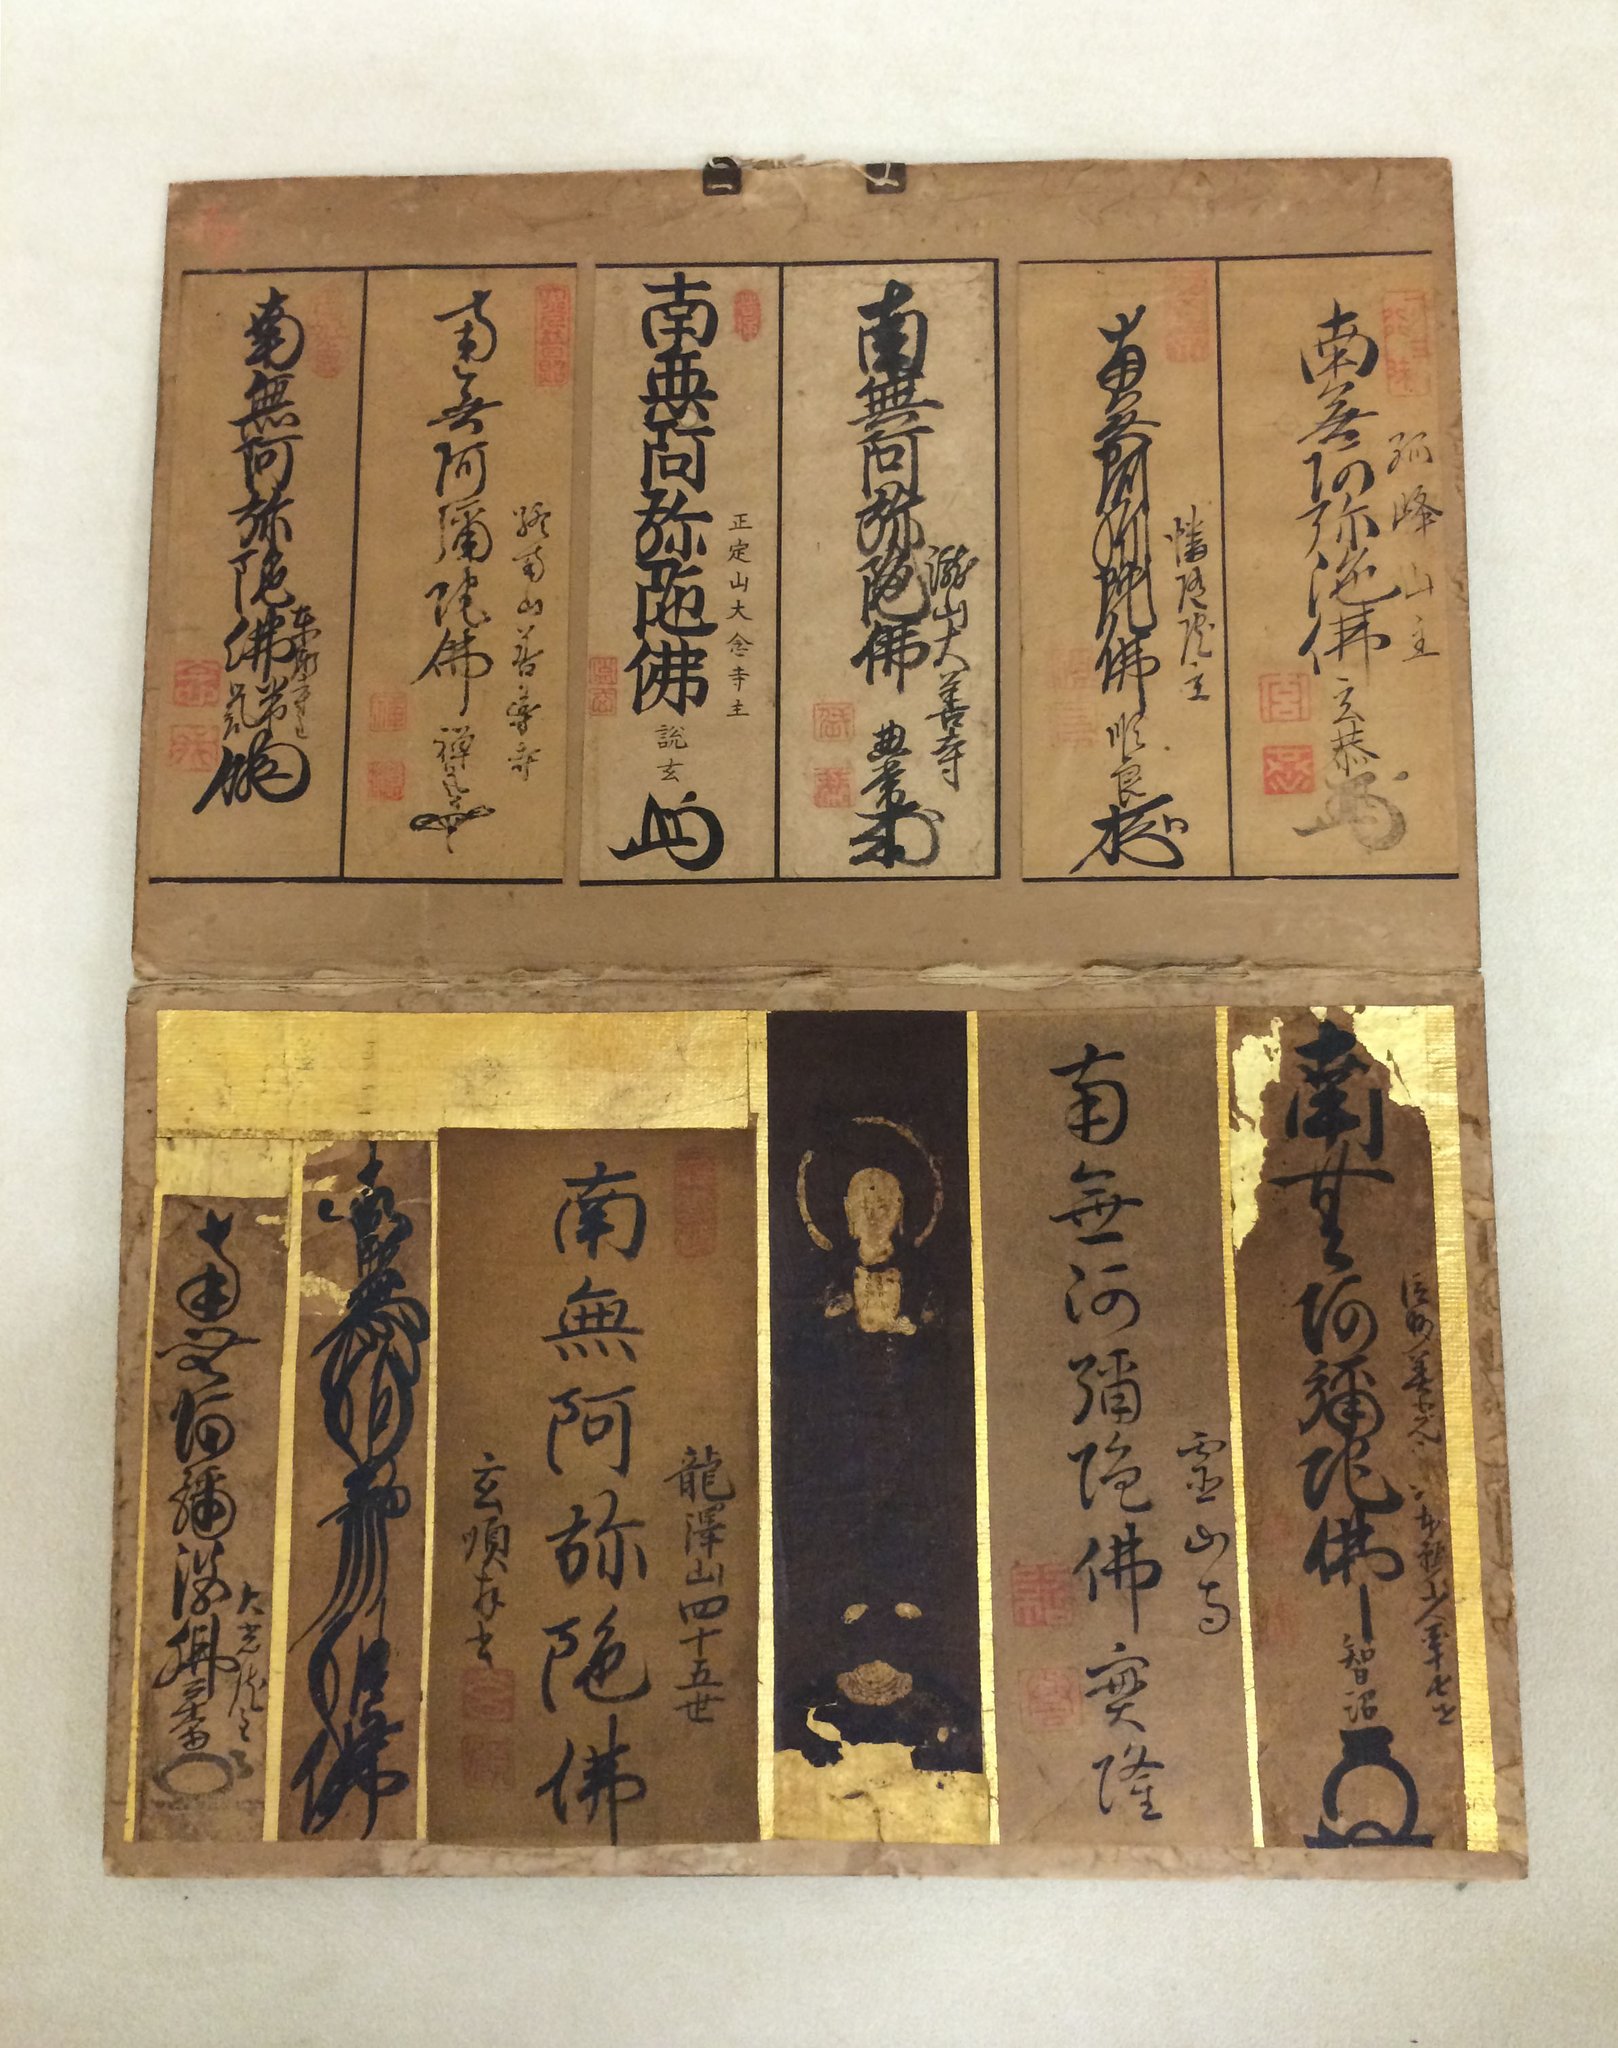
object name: book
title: Pilgrim's Visiting Album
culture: japanese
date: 1701-1800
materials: gilt, gold, ink, metal thread, paper, silk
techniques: calligraphy, embroidery, painting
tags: buddhism